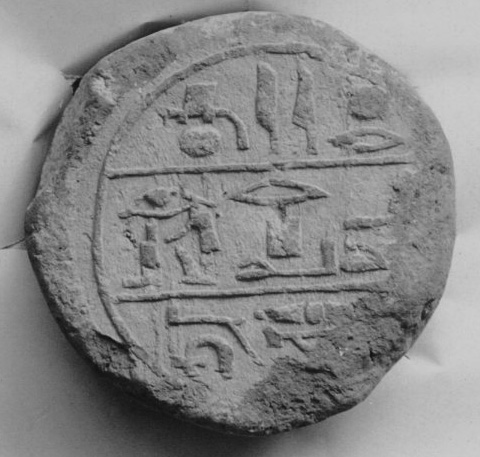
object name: cone, circular impression, min, overseer of the seal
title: Funerary Cone of the Overseer of the Seal Min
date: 1550-1295 BCE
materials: pottery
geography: egypt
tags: hieroglyphs